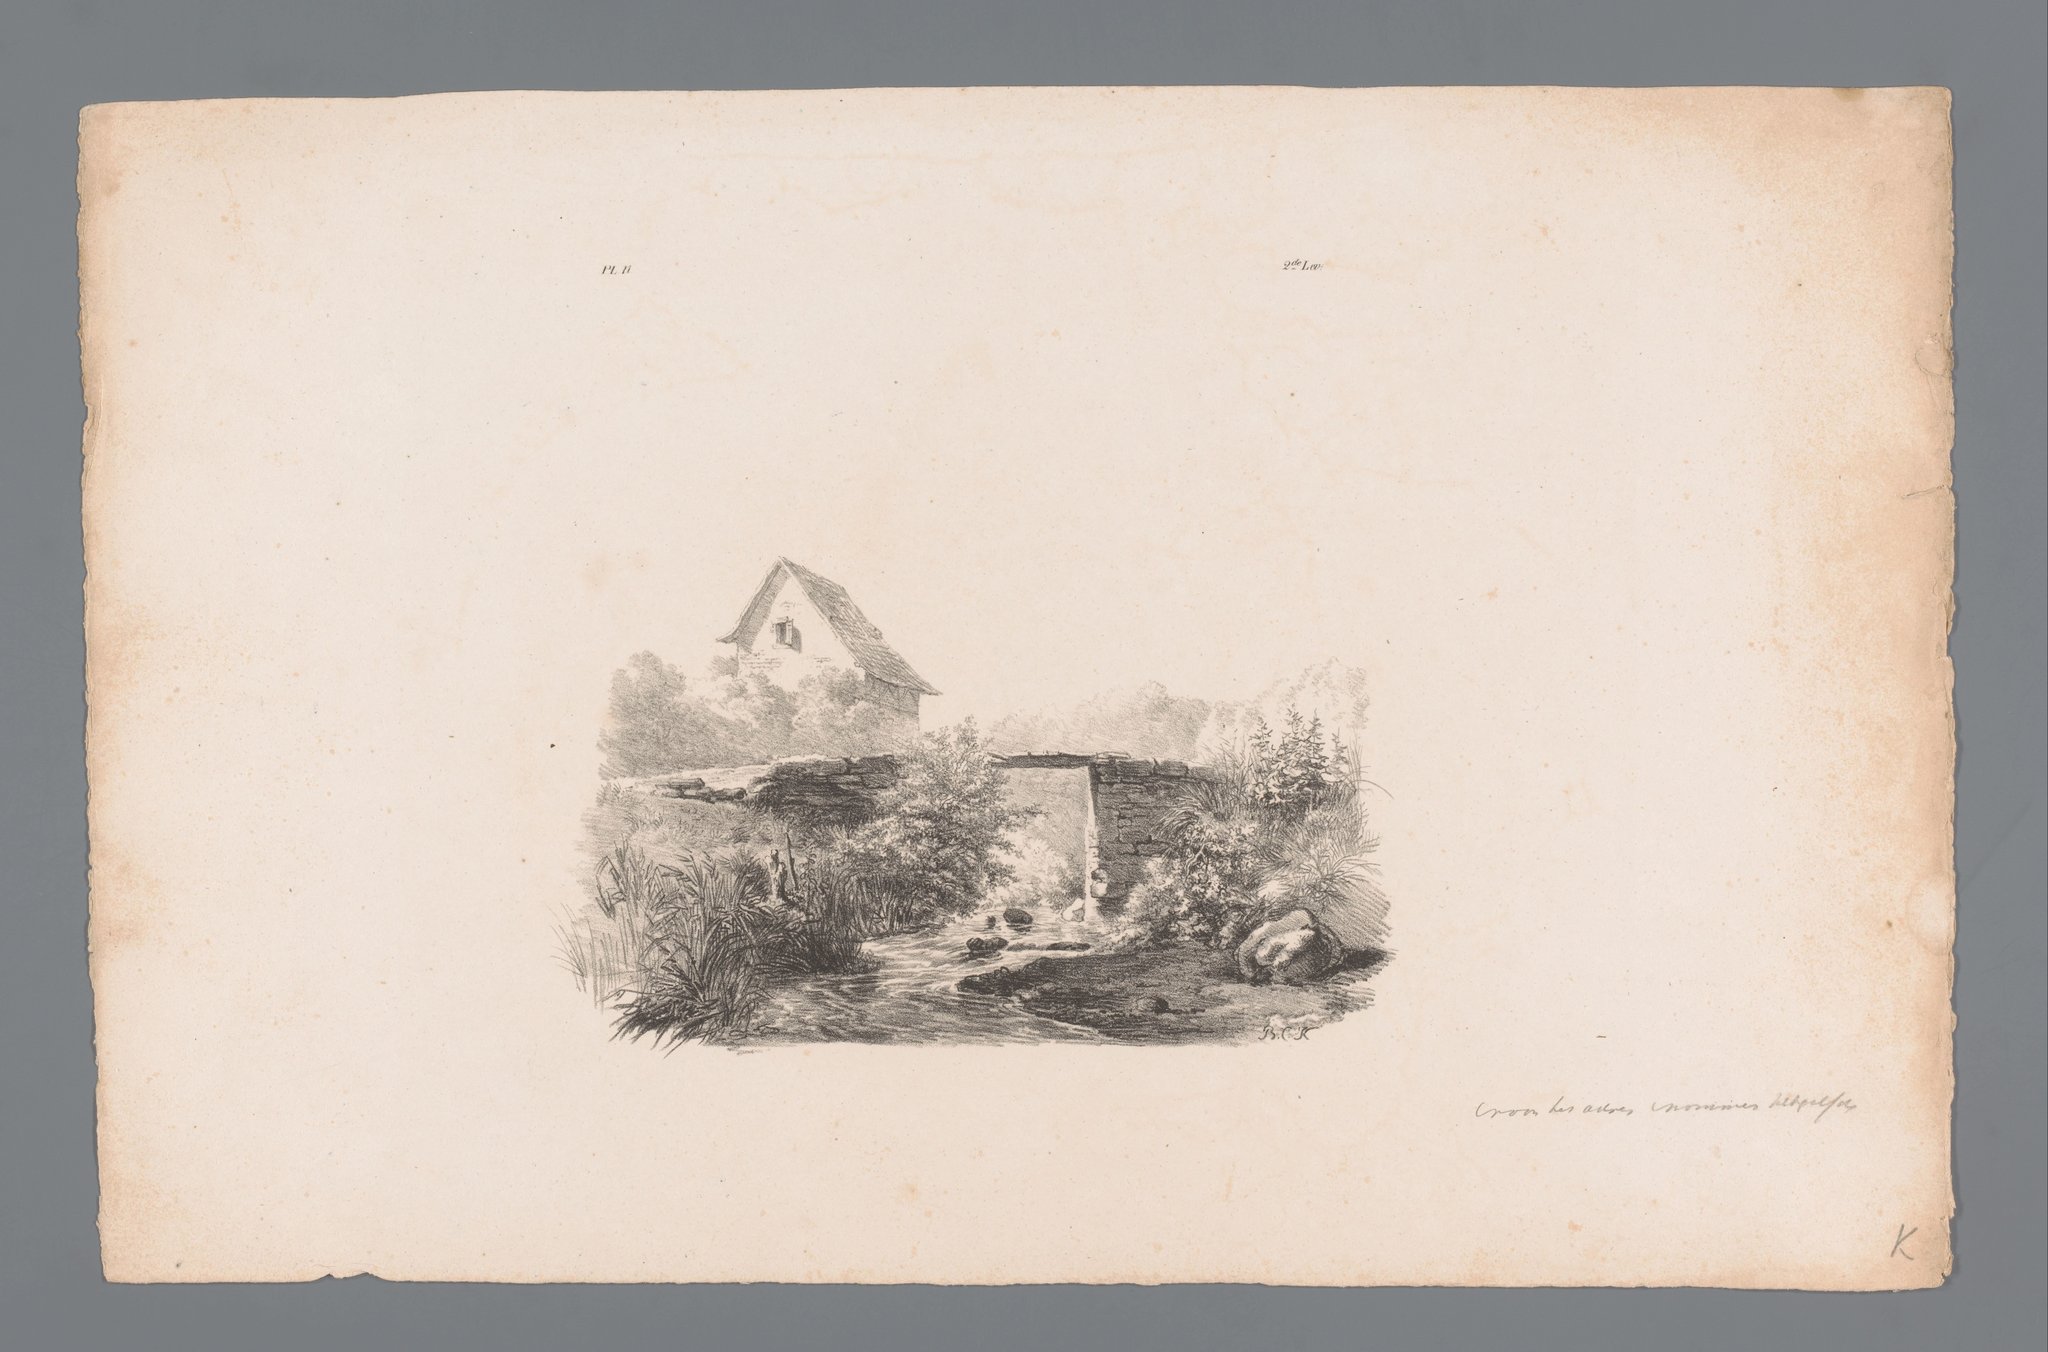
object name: print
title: Landschap met beek en huis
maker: barend cornelis koekkoek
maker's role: draughtsman, painter, print maker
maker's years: 1803-1862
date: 1829-1844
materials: paper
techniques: lithograph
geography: amsterdam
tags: landscape with bridge, viaduct or aqueduct, brook, farm or solitary house in landscape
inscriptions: collector's mark: Lugt 2228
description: In 1829 en 1830 gaf Koekkoek, samen met Daiwaille, zes cahiers uit met ieder zes prenten getiteld Landschapstudiën. Deze werden gebruikt in het tekenonderwijs. Vijftien jaar later werd deze reeks, in een andere samenstelling nogmaals uitgegeven door Meyer en Comp in Amsterdam. Zie: De Bruyn Kops, 1963.